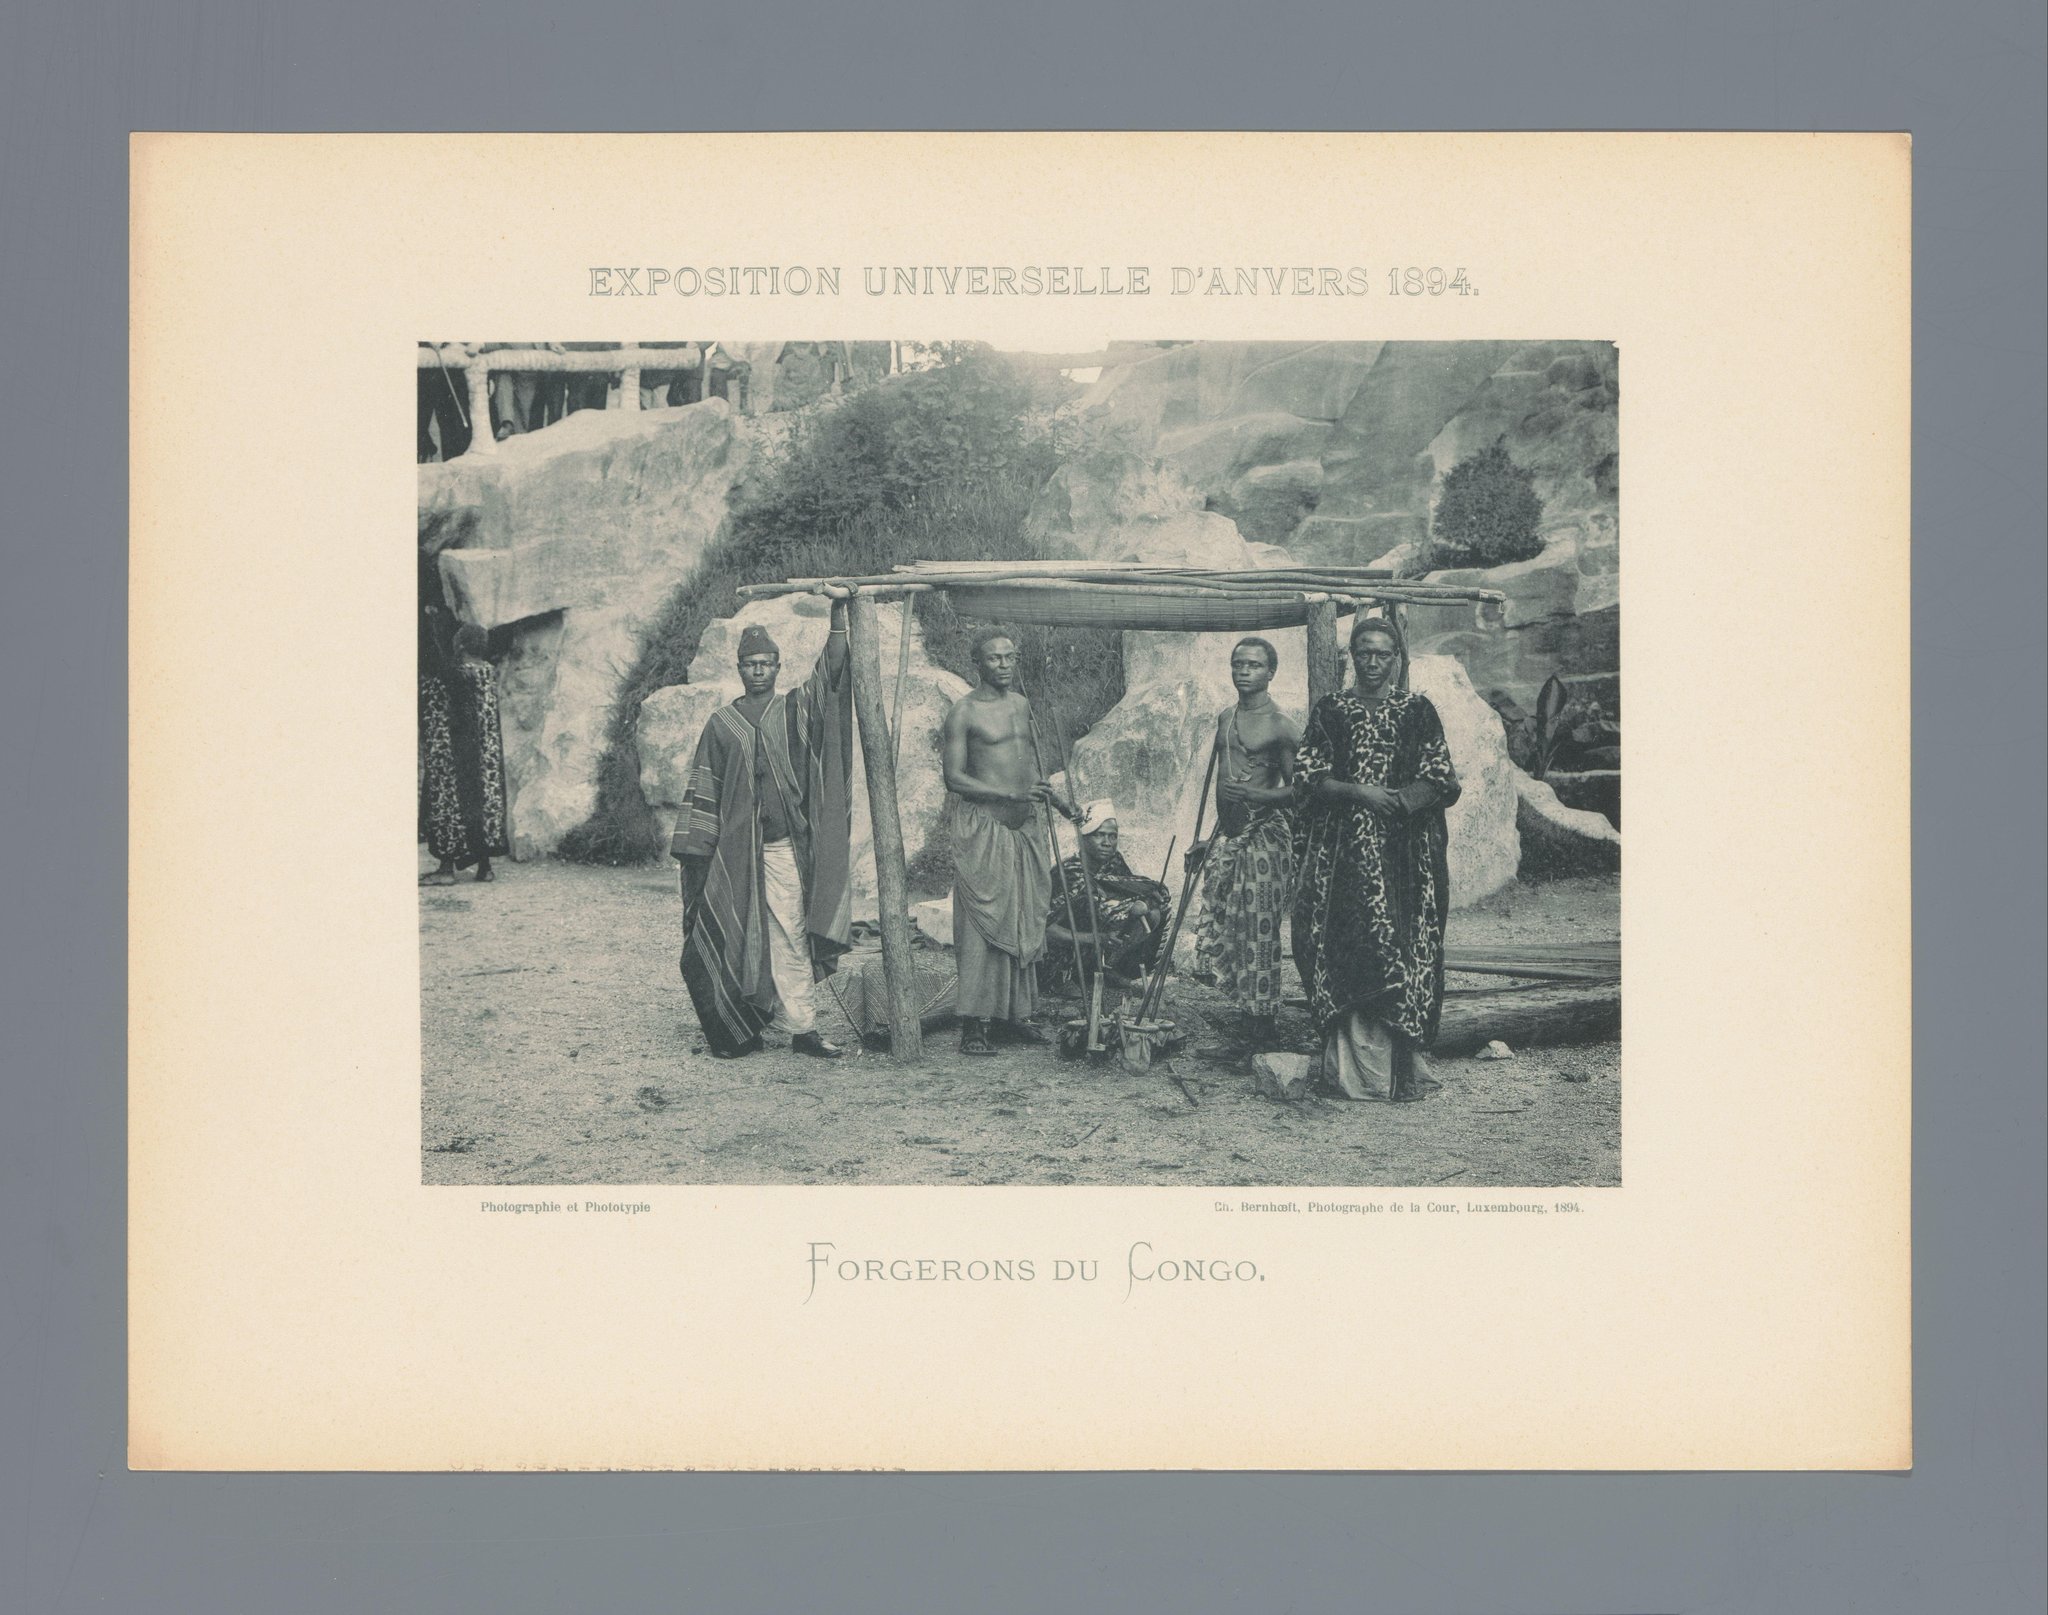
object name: photomechanical print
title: Vijf onbekende Congolese personen bij het paviljoen van Congo tijdens de Wereldtentoonstelling van 1894 te Antwerpen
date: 1894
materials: paper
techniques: photograph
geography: antwerp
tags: world fair, world exhibition, africans, historical persons, antwerp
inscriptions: inscription: ‘Exposition Universelle D'Anvers 1894.’